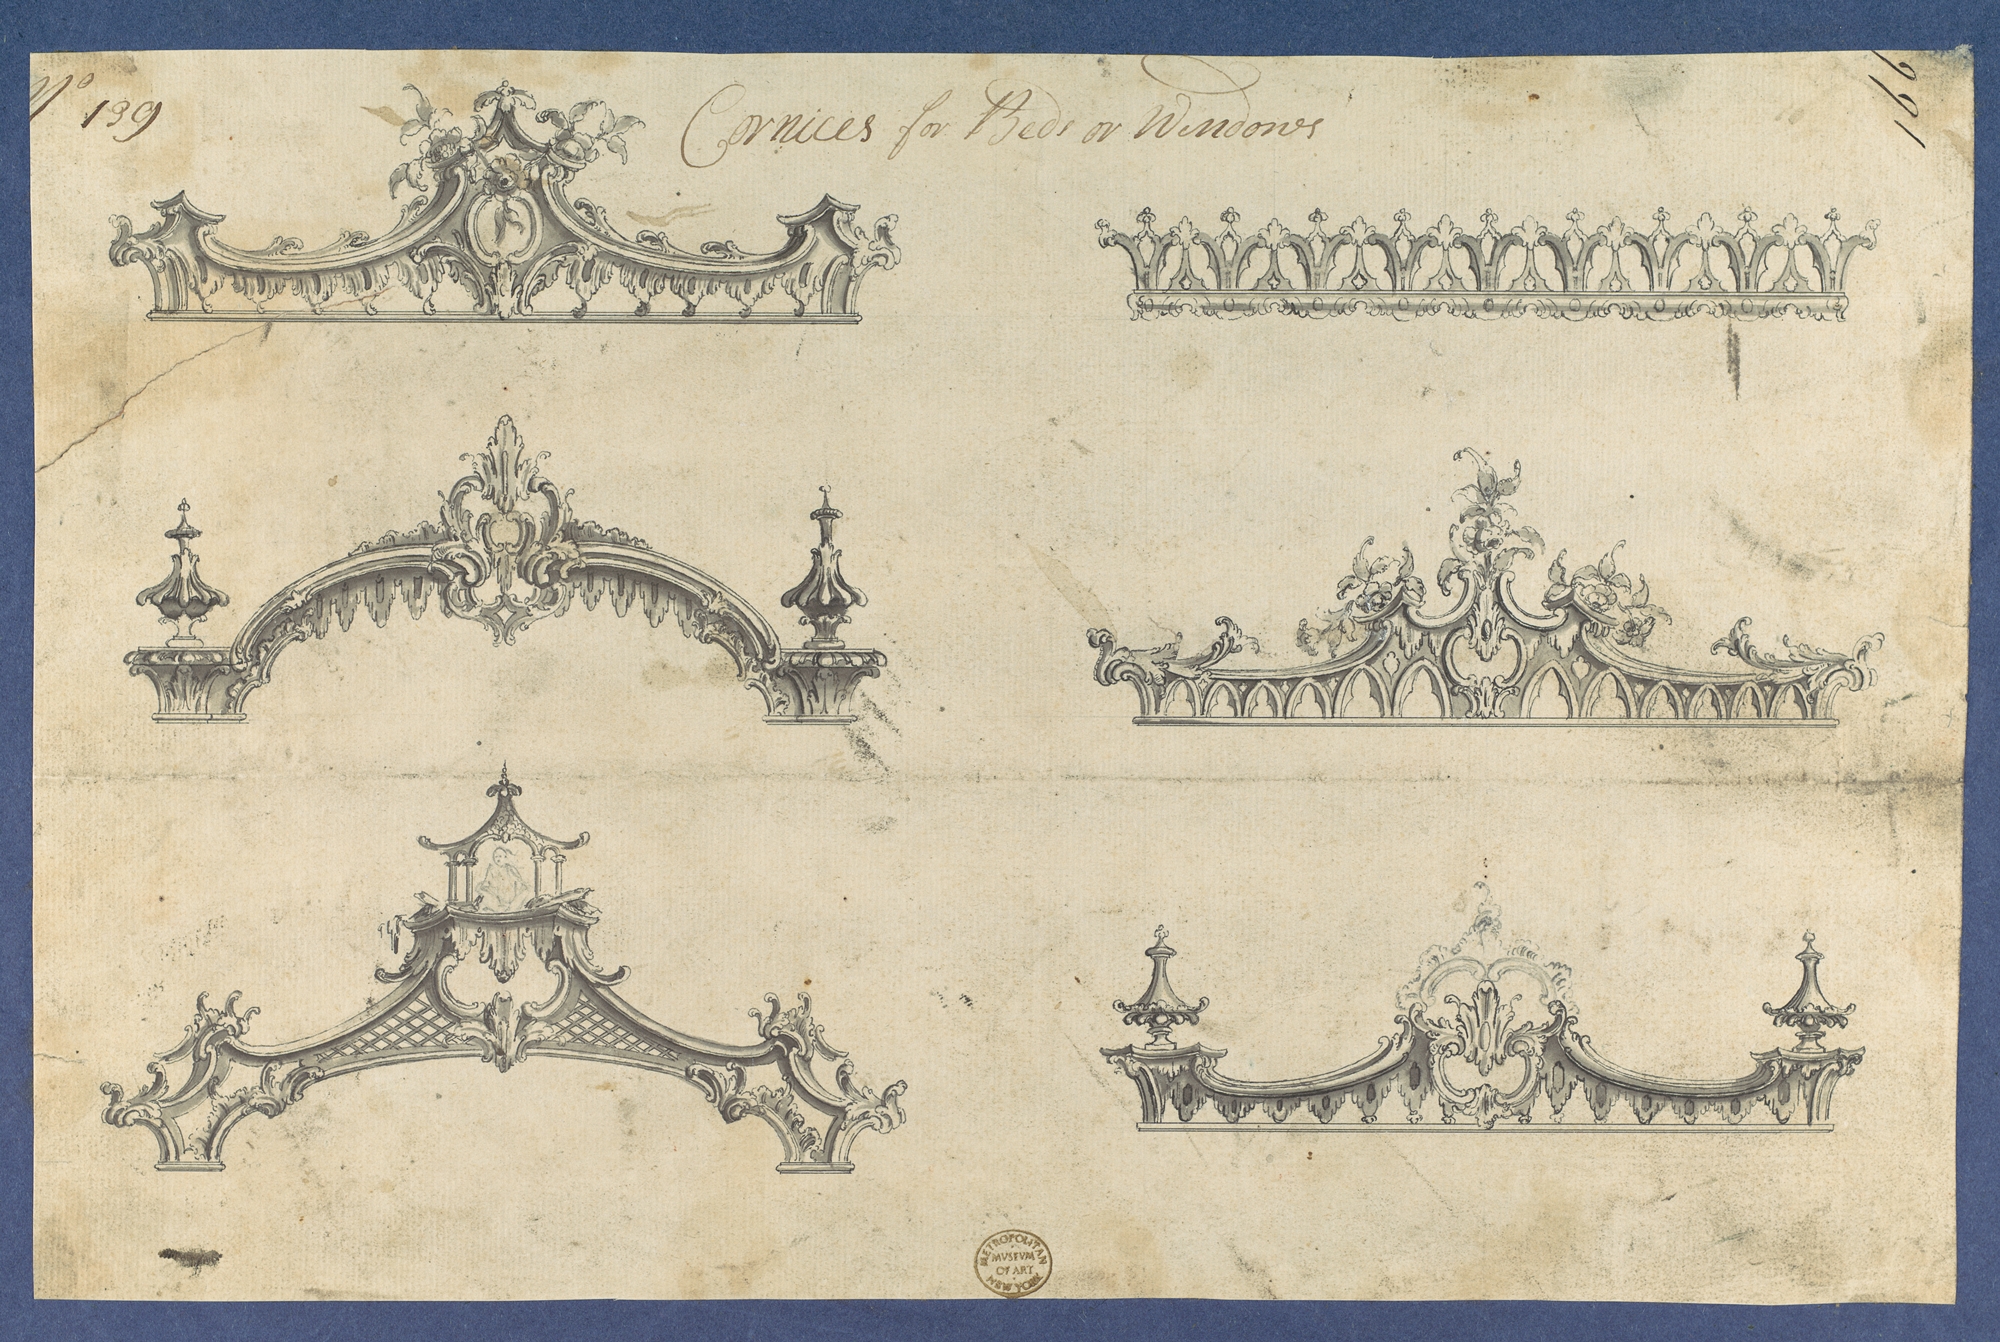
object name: drawing ornament architecture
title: Cornices for Beds or Windows, in Chippendale Drawings, Vol. I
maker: thomas chippendale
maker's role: artist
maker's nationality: british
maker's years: 1718-1779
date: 1754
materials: ink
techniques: wash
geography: london